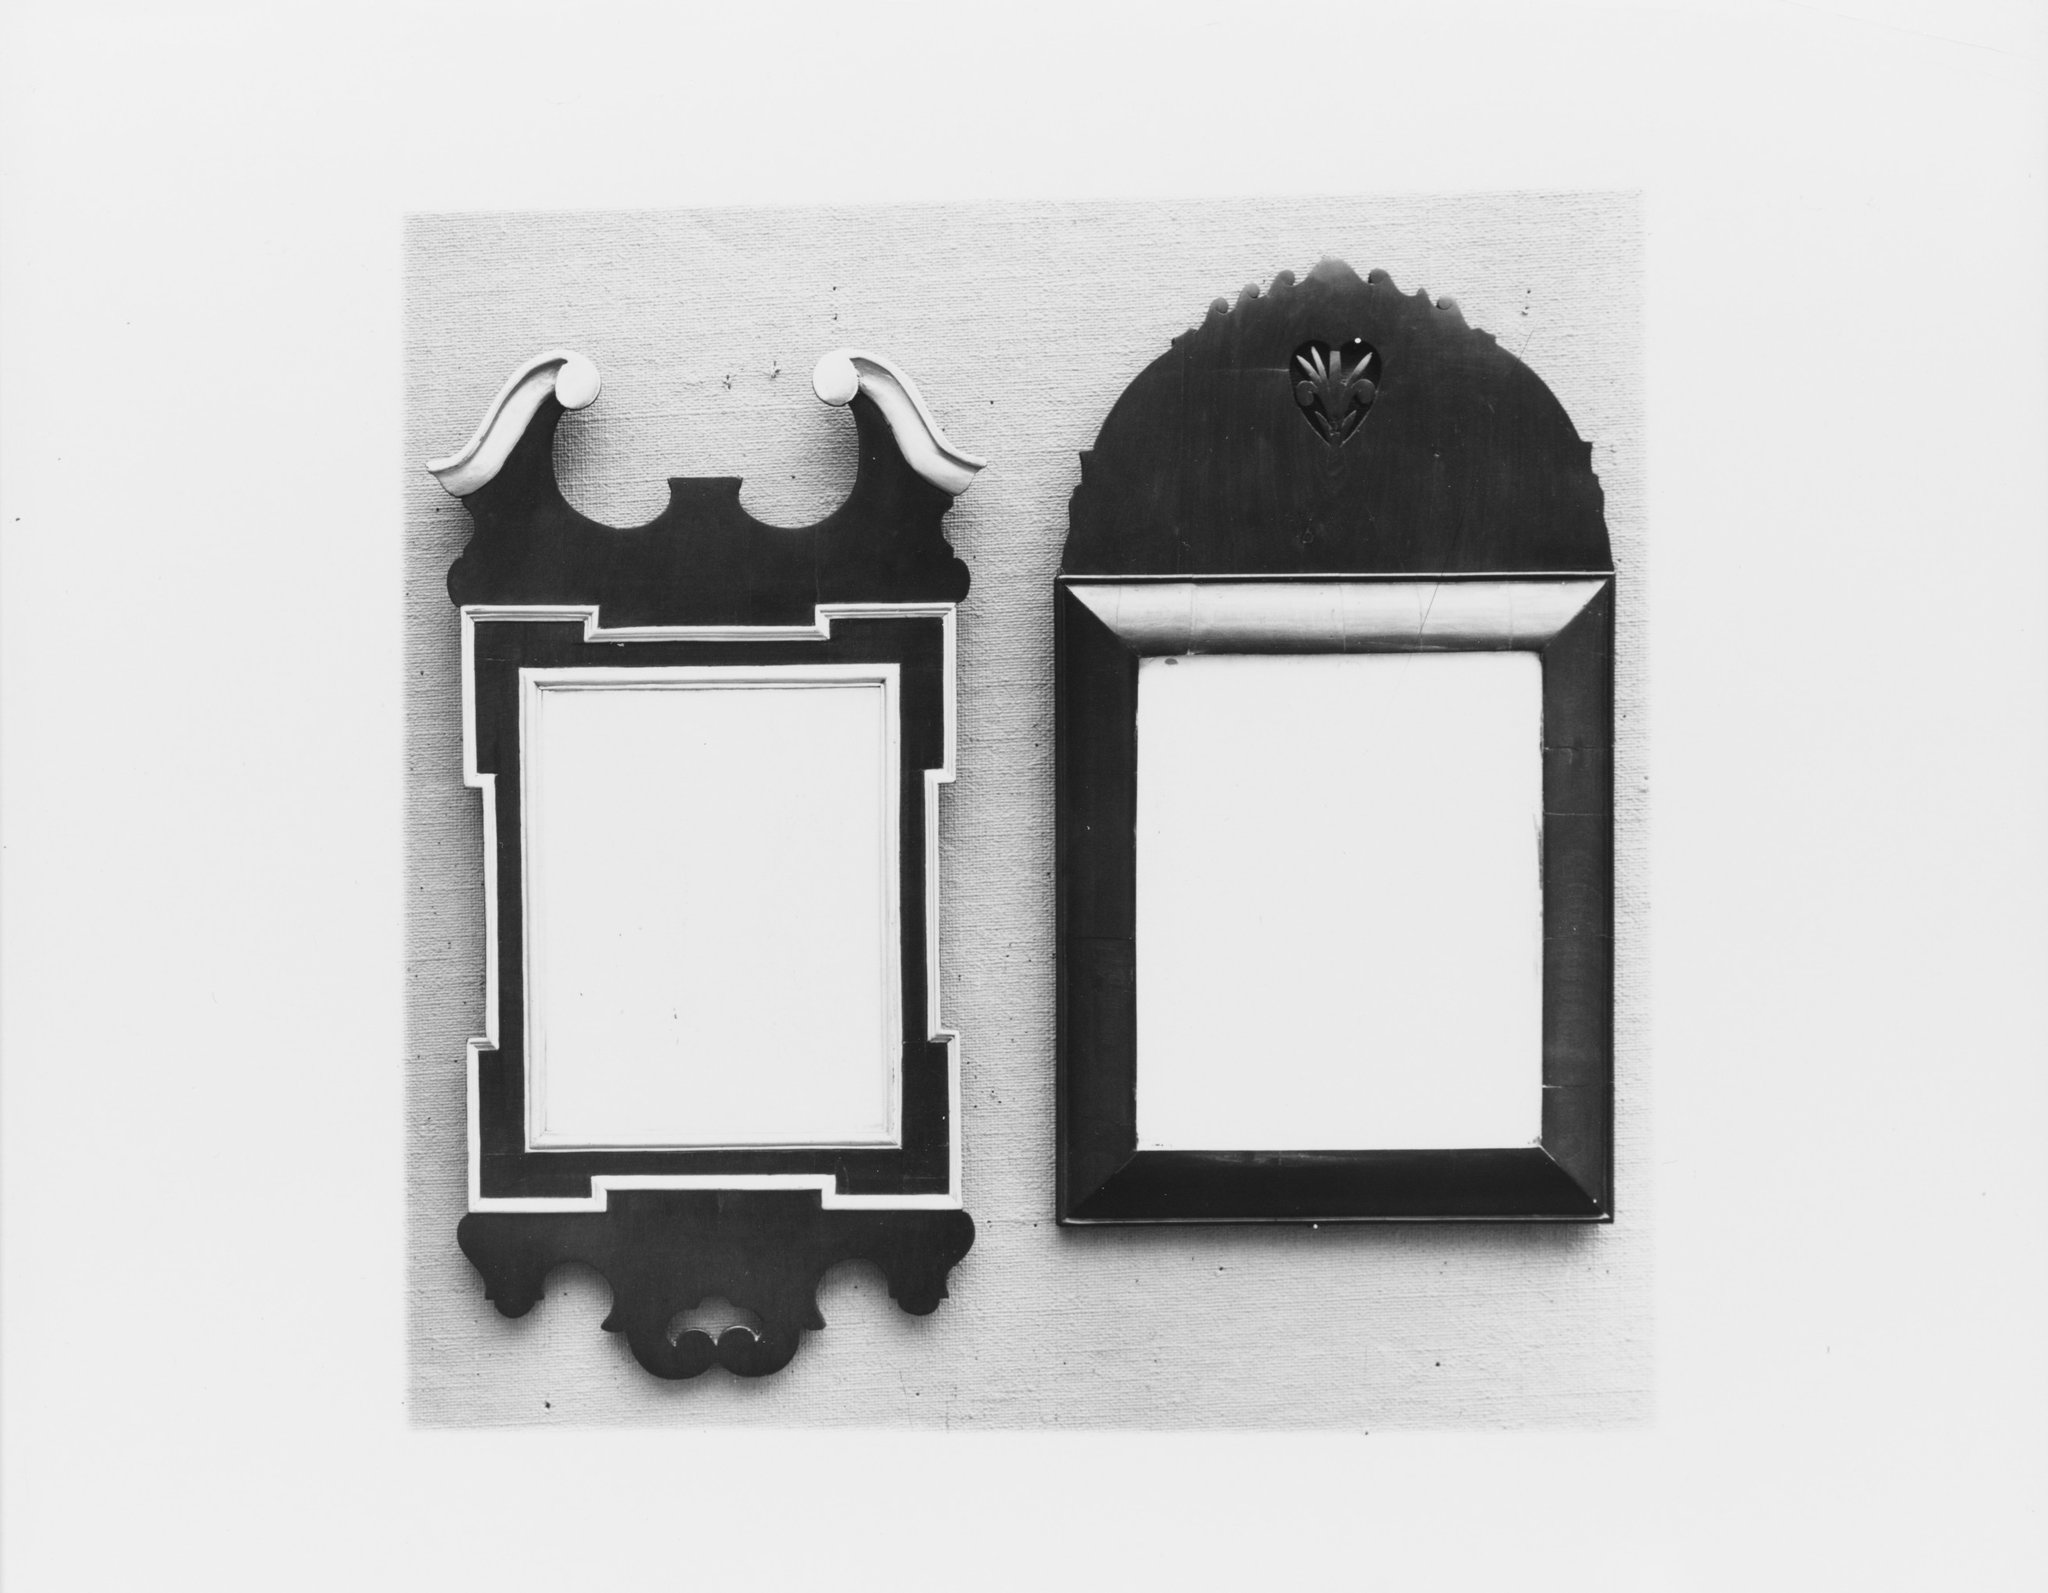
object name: looking glass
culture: american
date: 1700-1720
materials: glass, wood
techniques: veneering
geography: england